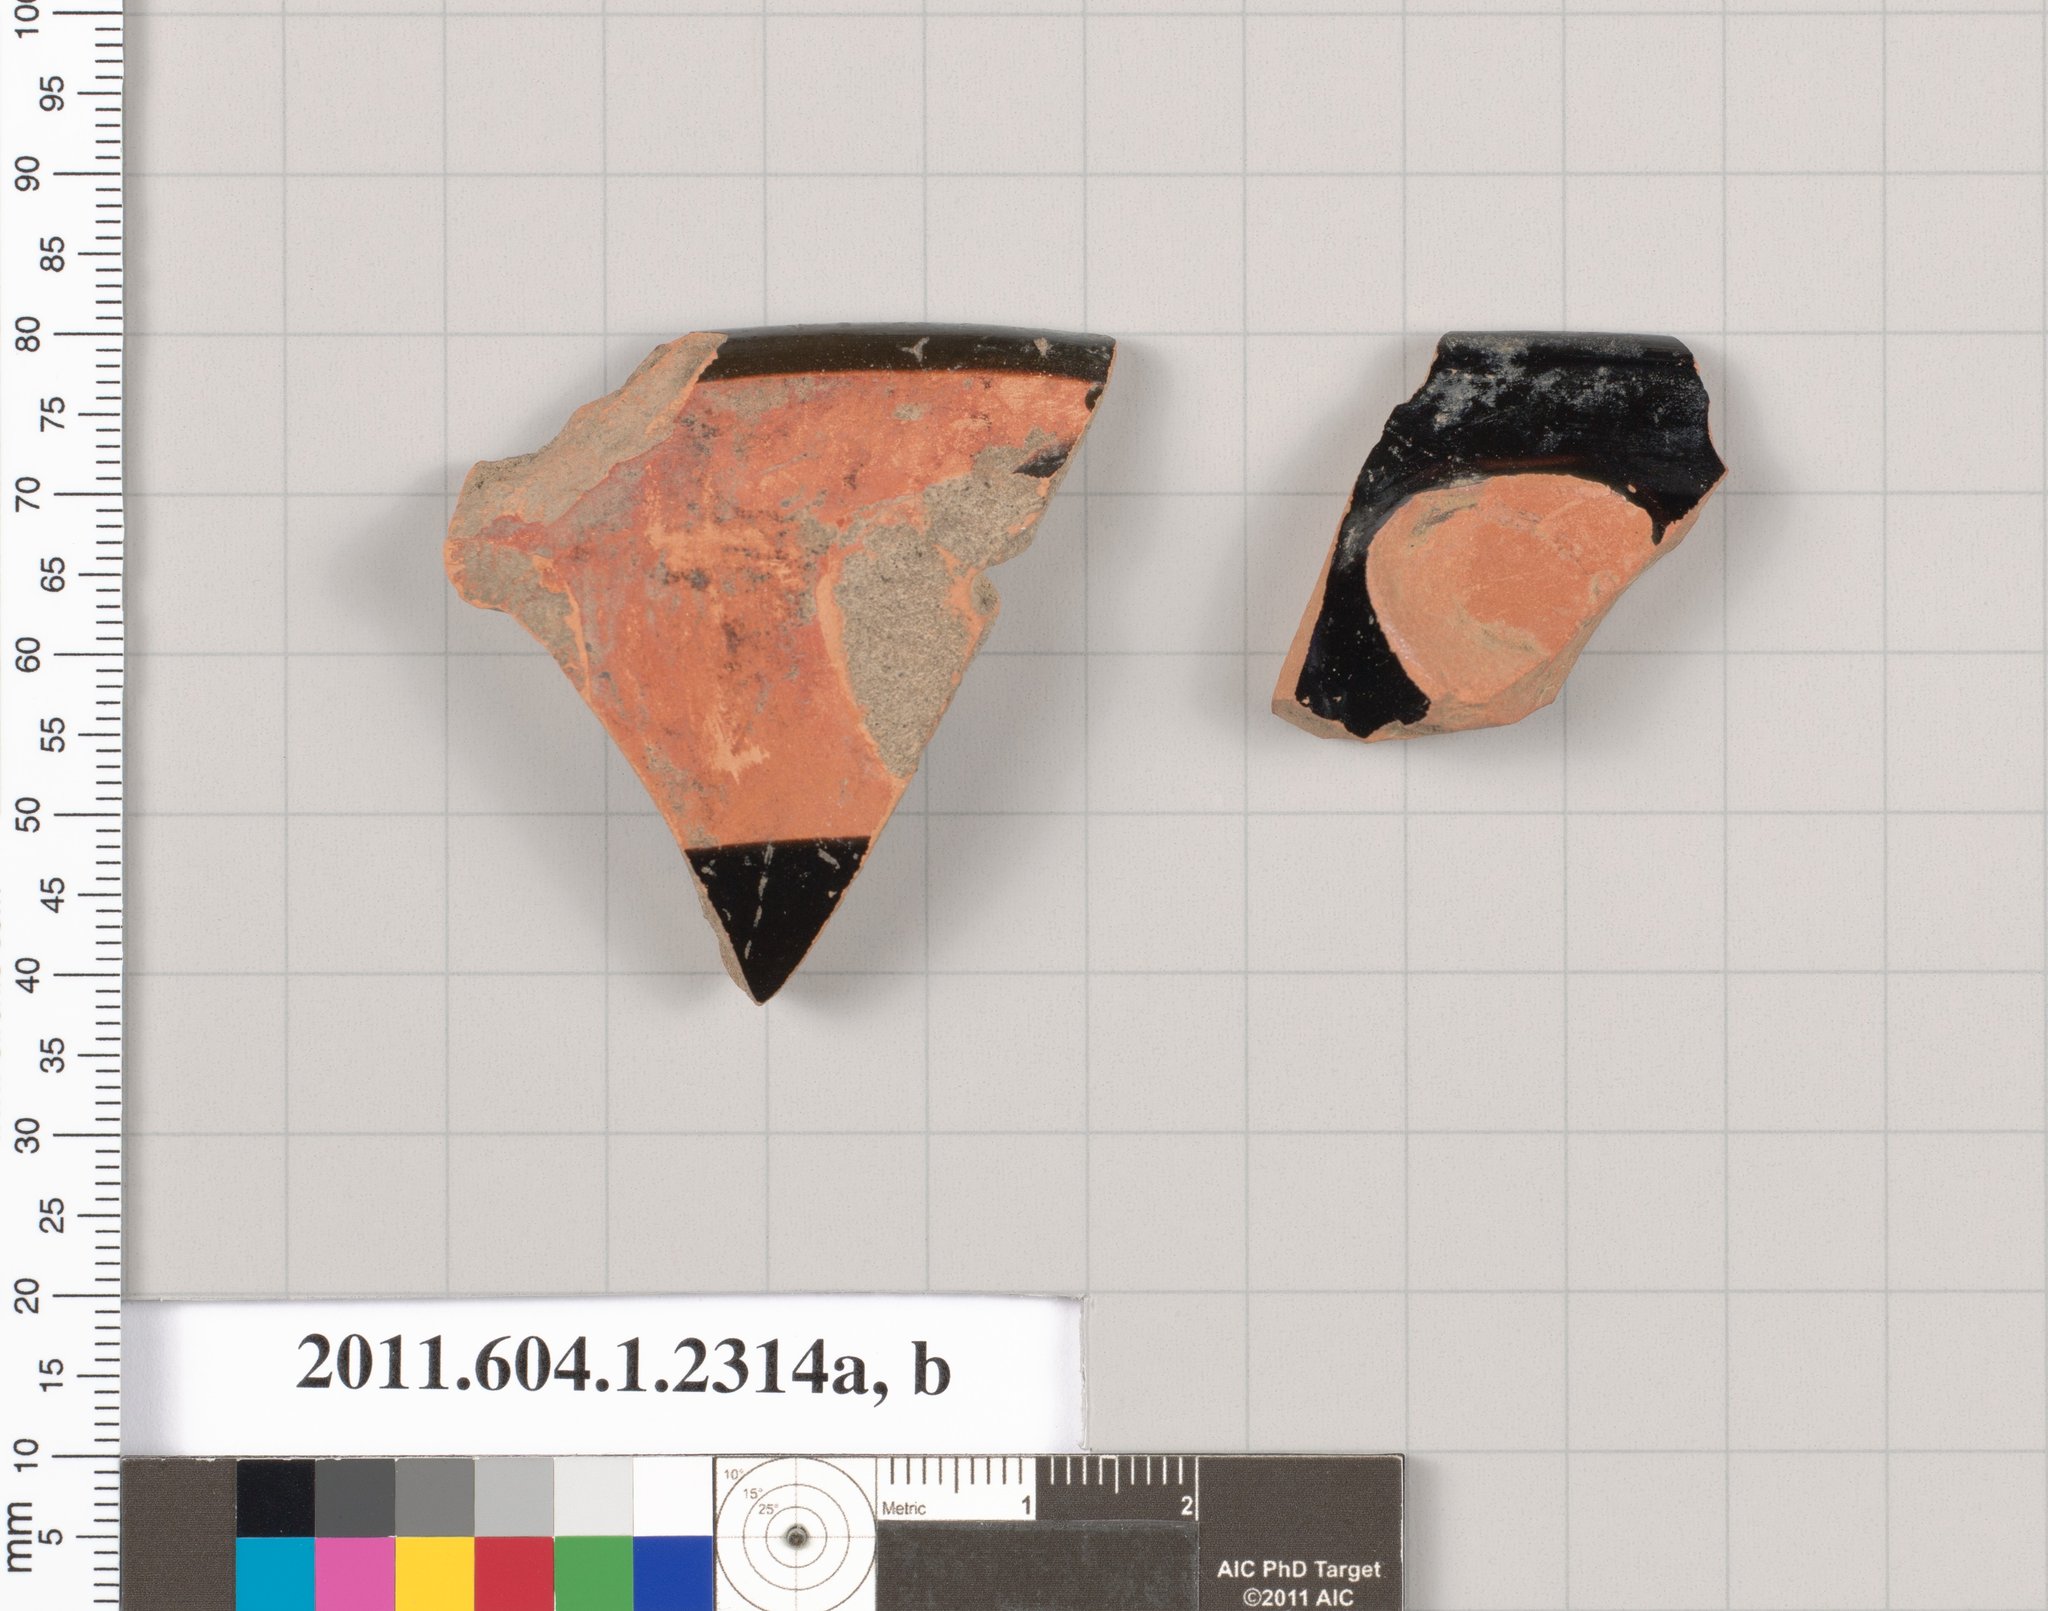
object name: kylix fragment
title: Terracotta rim fragments of kylikes (drinking cups)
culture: greek, attic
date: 500-451 BCE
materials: terracotta